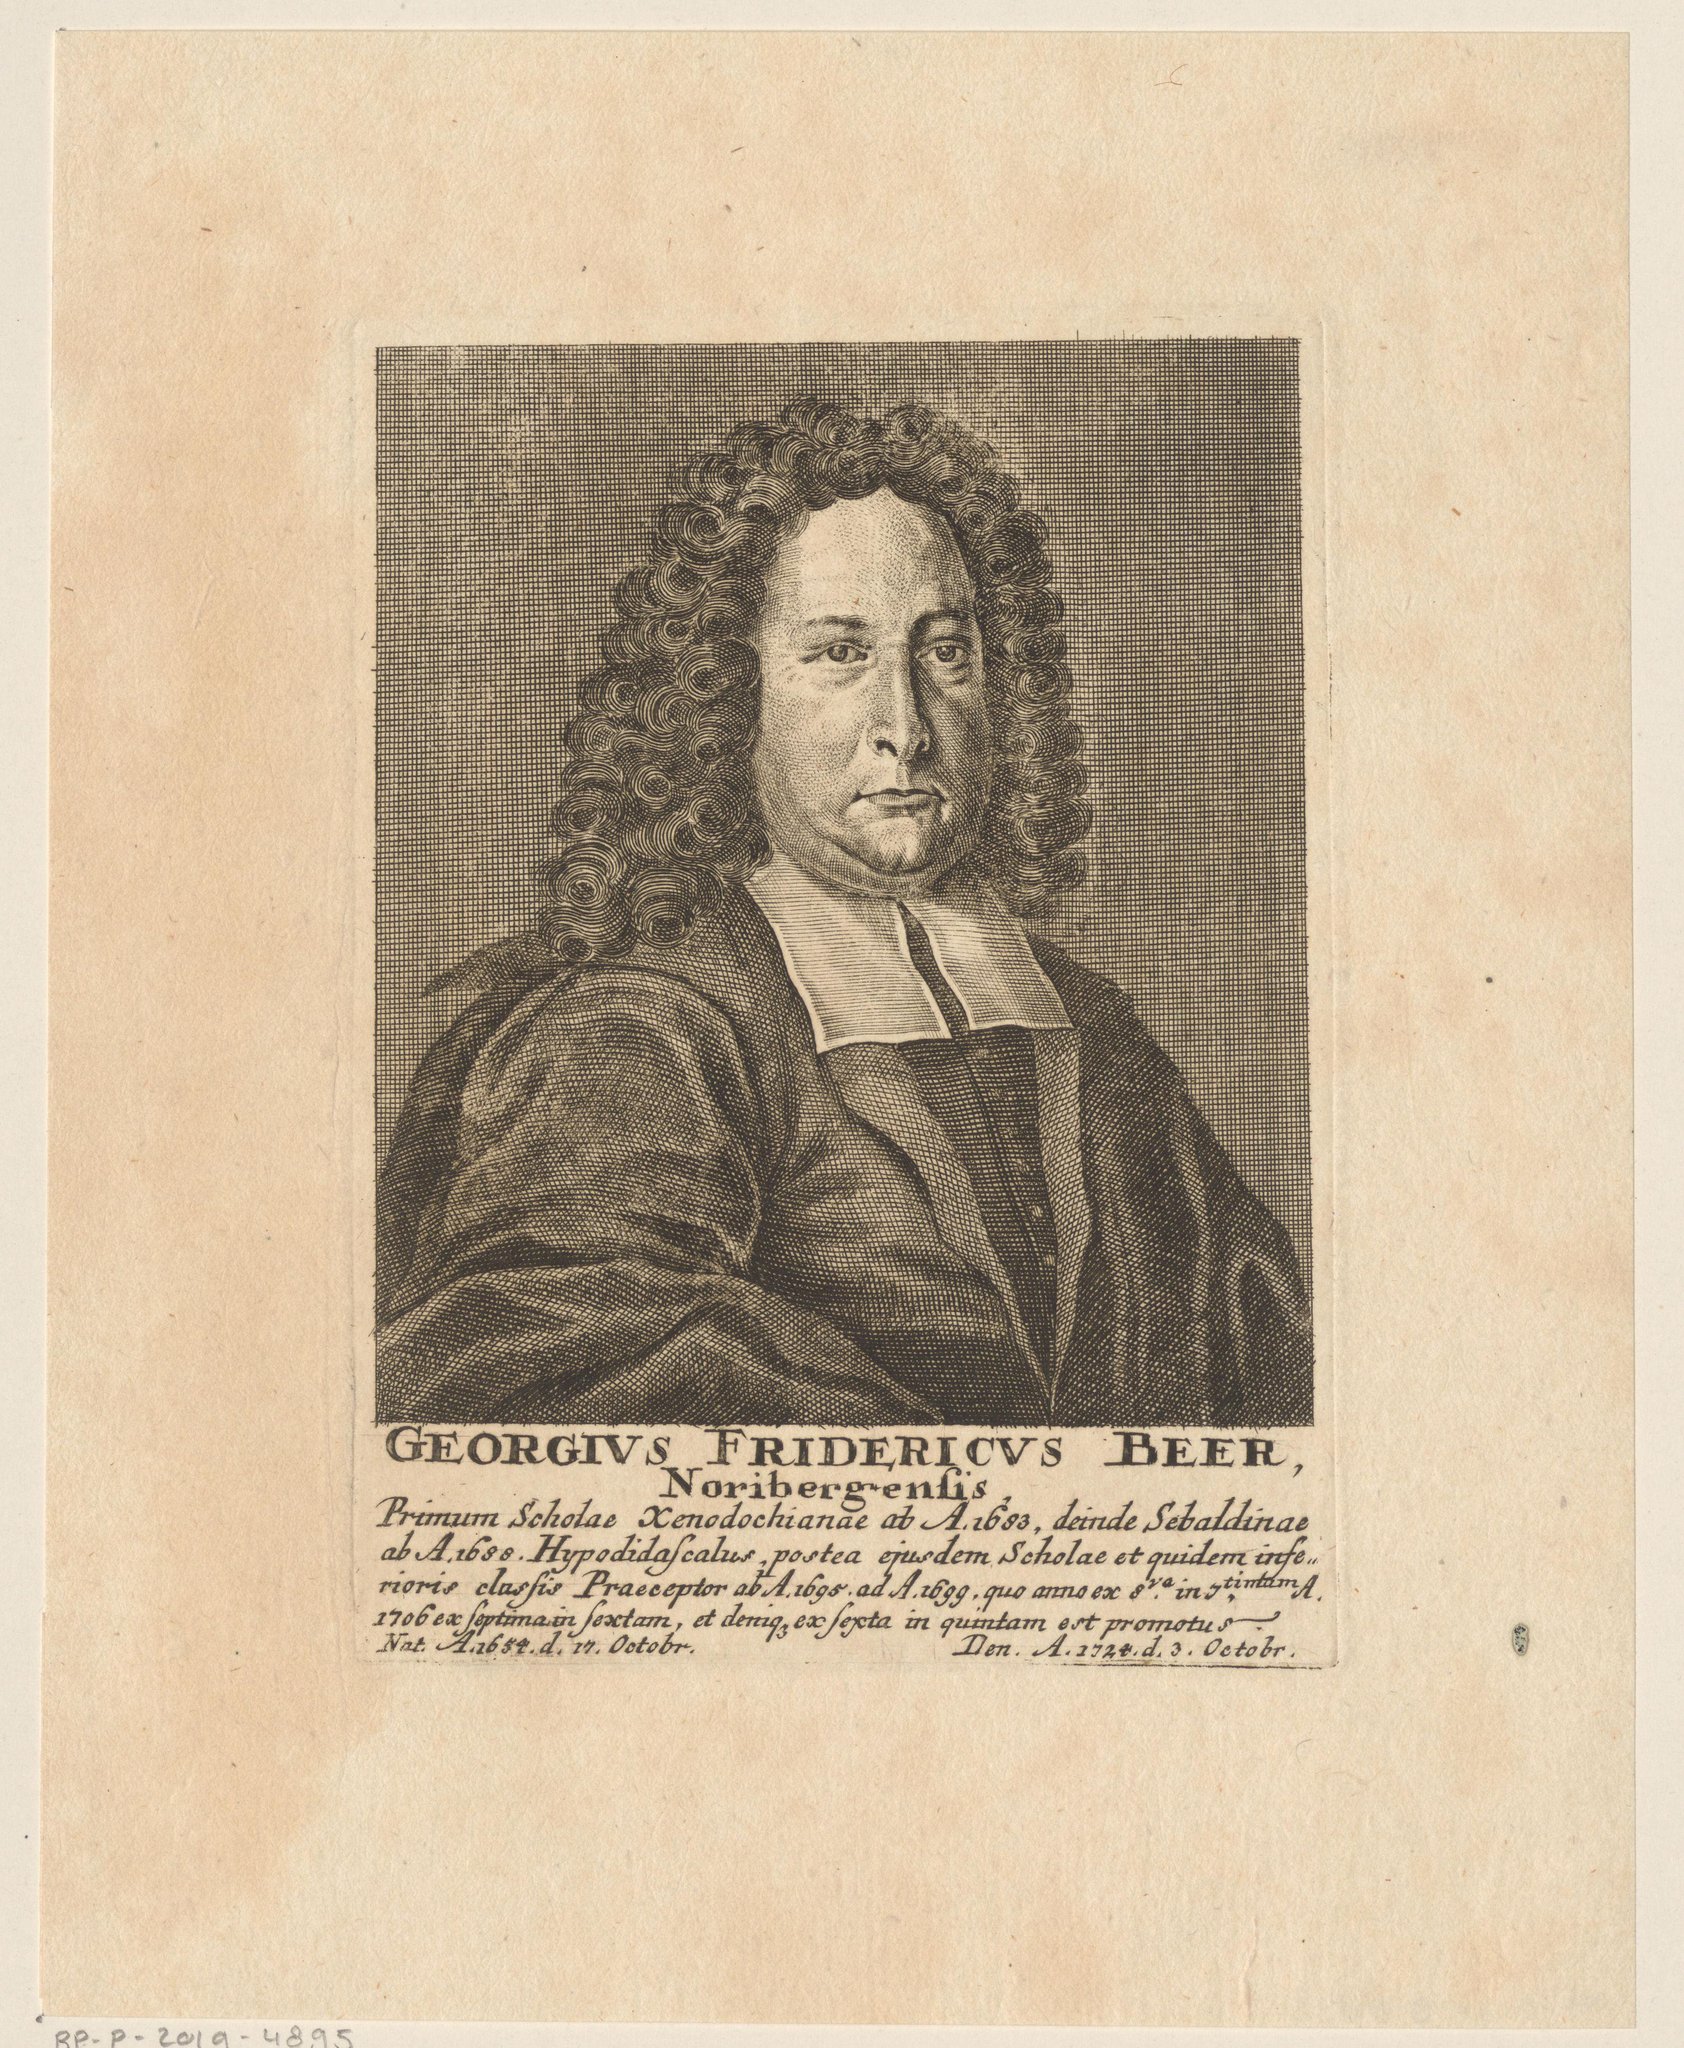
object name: print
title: Portret van Georg Friedrich Beer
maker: Anonymous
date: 1724-1749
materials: paper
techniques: engraving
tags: historical persons